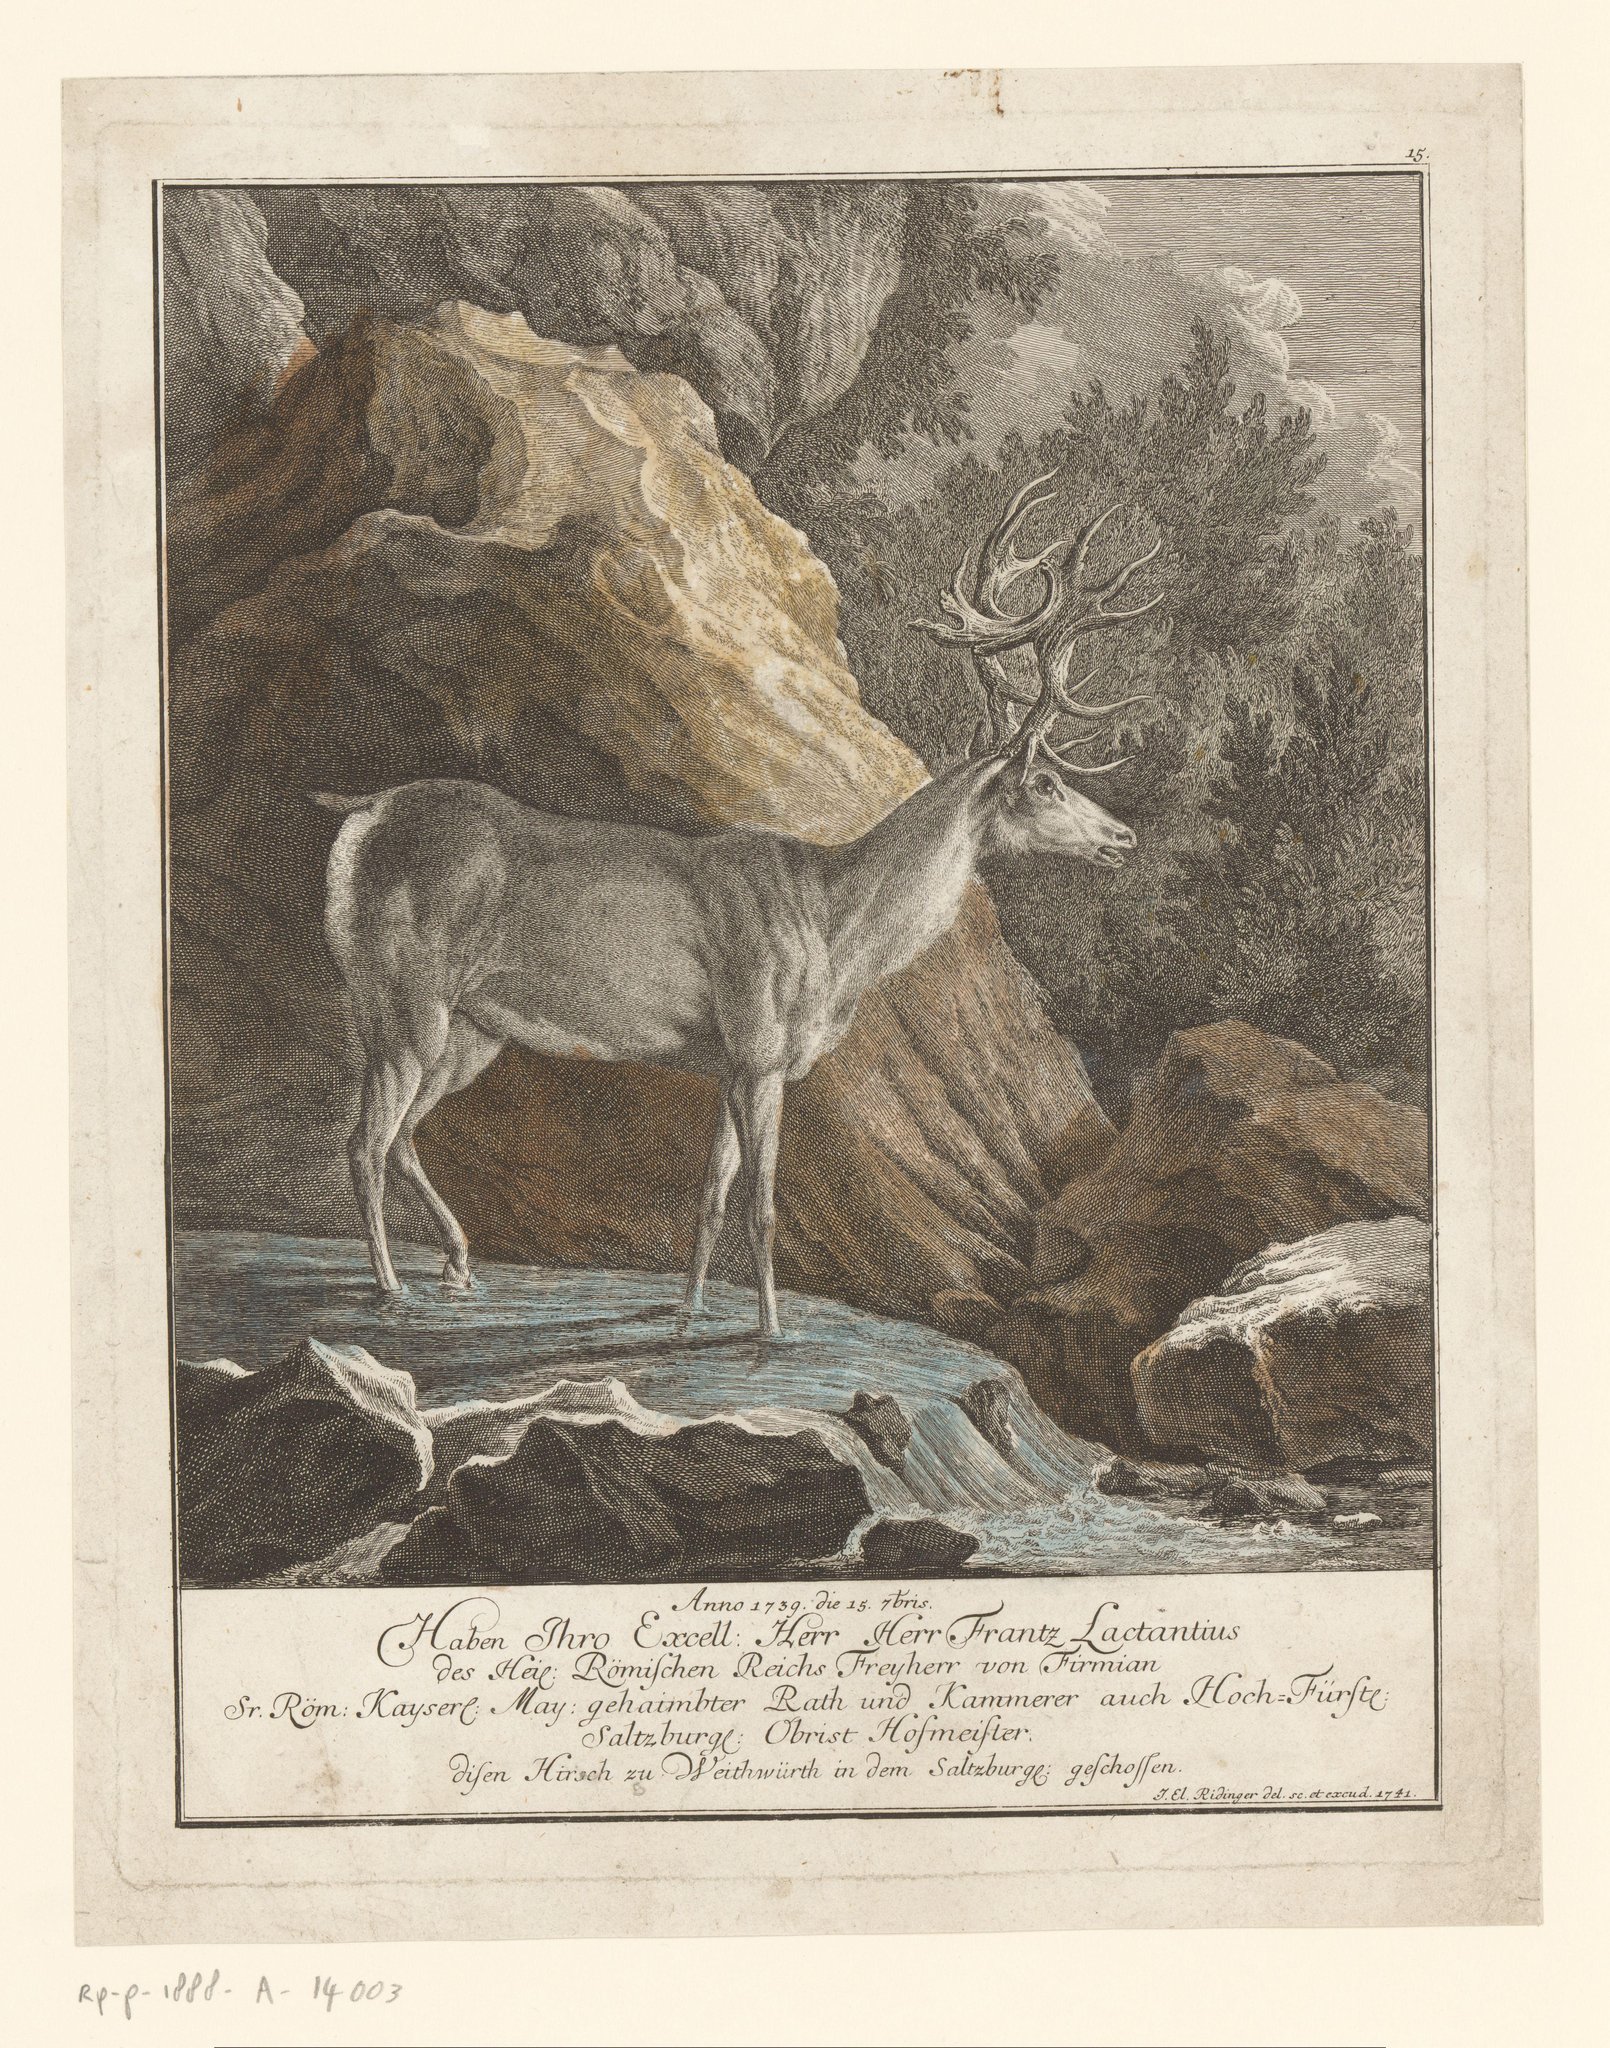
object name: print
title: Hert met bijzonder gewei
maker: johann elias ridinger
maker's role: draughtsman, painter, print maker, publisher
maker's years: 1698-1767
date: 1741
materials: paper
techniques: etching, hand coloring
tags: leopold anton von firmian, hoofed animals: deer, landscapes - hh - ideal landscapes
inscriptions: collector's mark: Lugt 2228